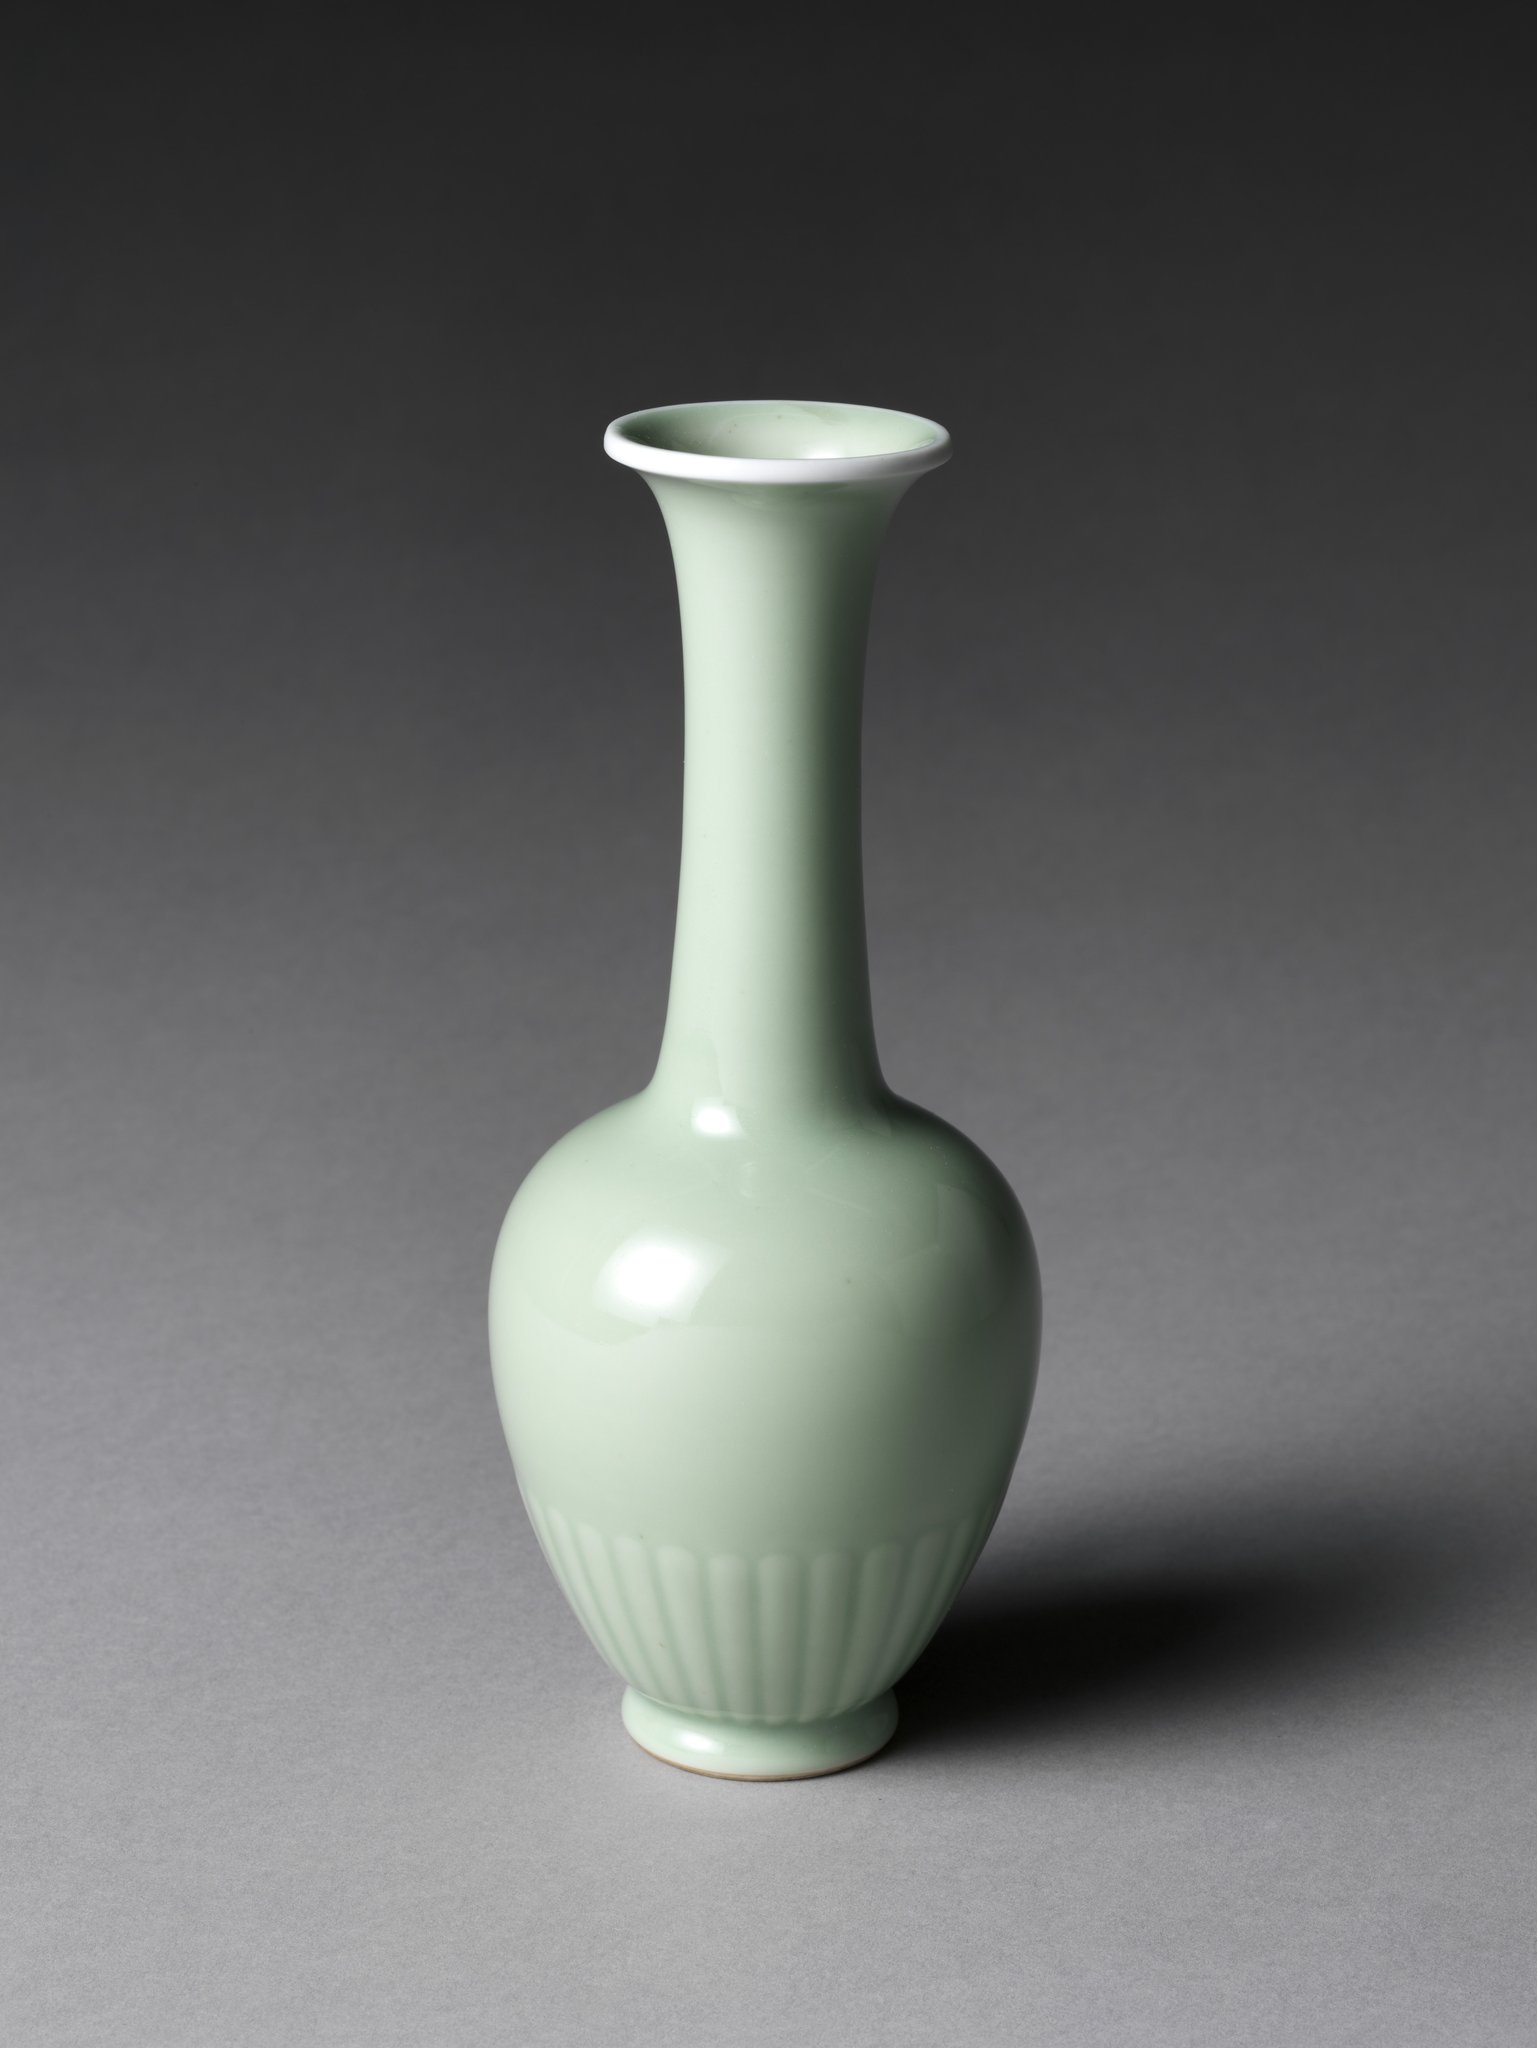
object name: vase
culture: chinese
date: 1678-1688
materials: ceramic glaze, glaze, porcelain